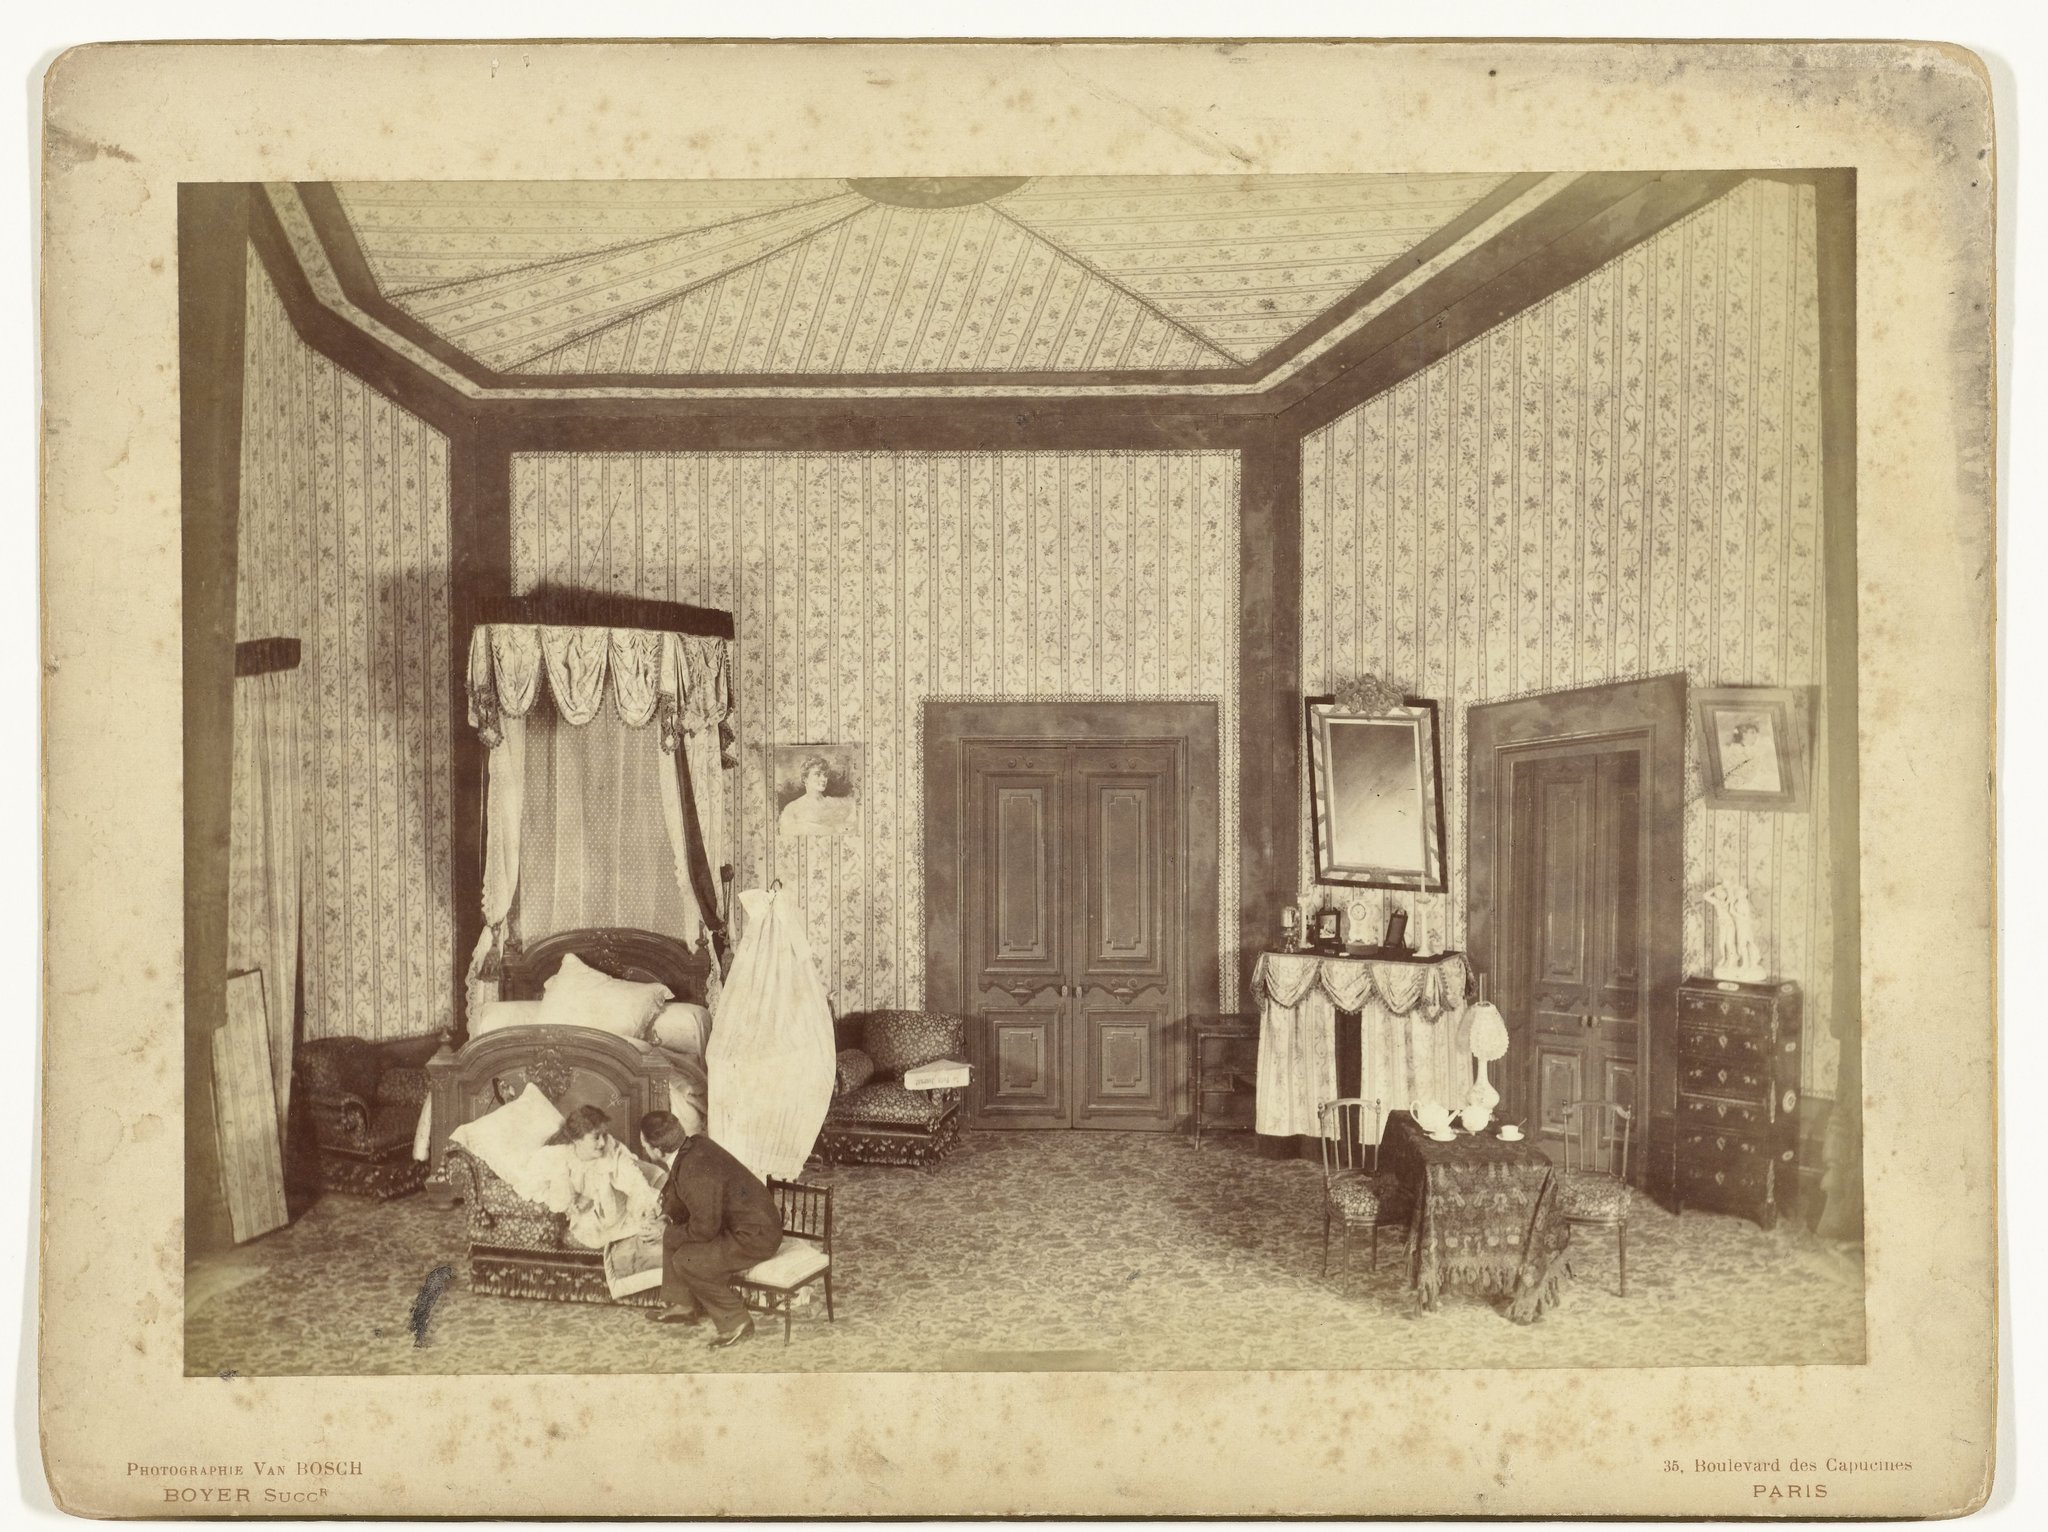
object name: photograph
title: Scène uit het toneelstuk Musotte van Jacques Normand in het Théâtre du Gymnase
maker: paul boyer (1861-1908)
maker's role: fotograaf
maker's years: 1861-1952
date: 1891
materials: cardboard, paper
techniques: albumen print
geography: paris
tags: theatre, theatrical performance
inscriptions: address: ‘35. Boulevard des Capucines Paris’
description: Het toneelstuk Musotte werd geïnspireerd door het gelijknamige boek van Guy de Maupassant.